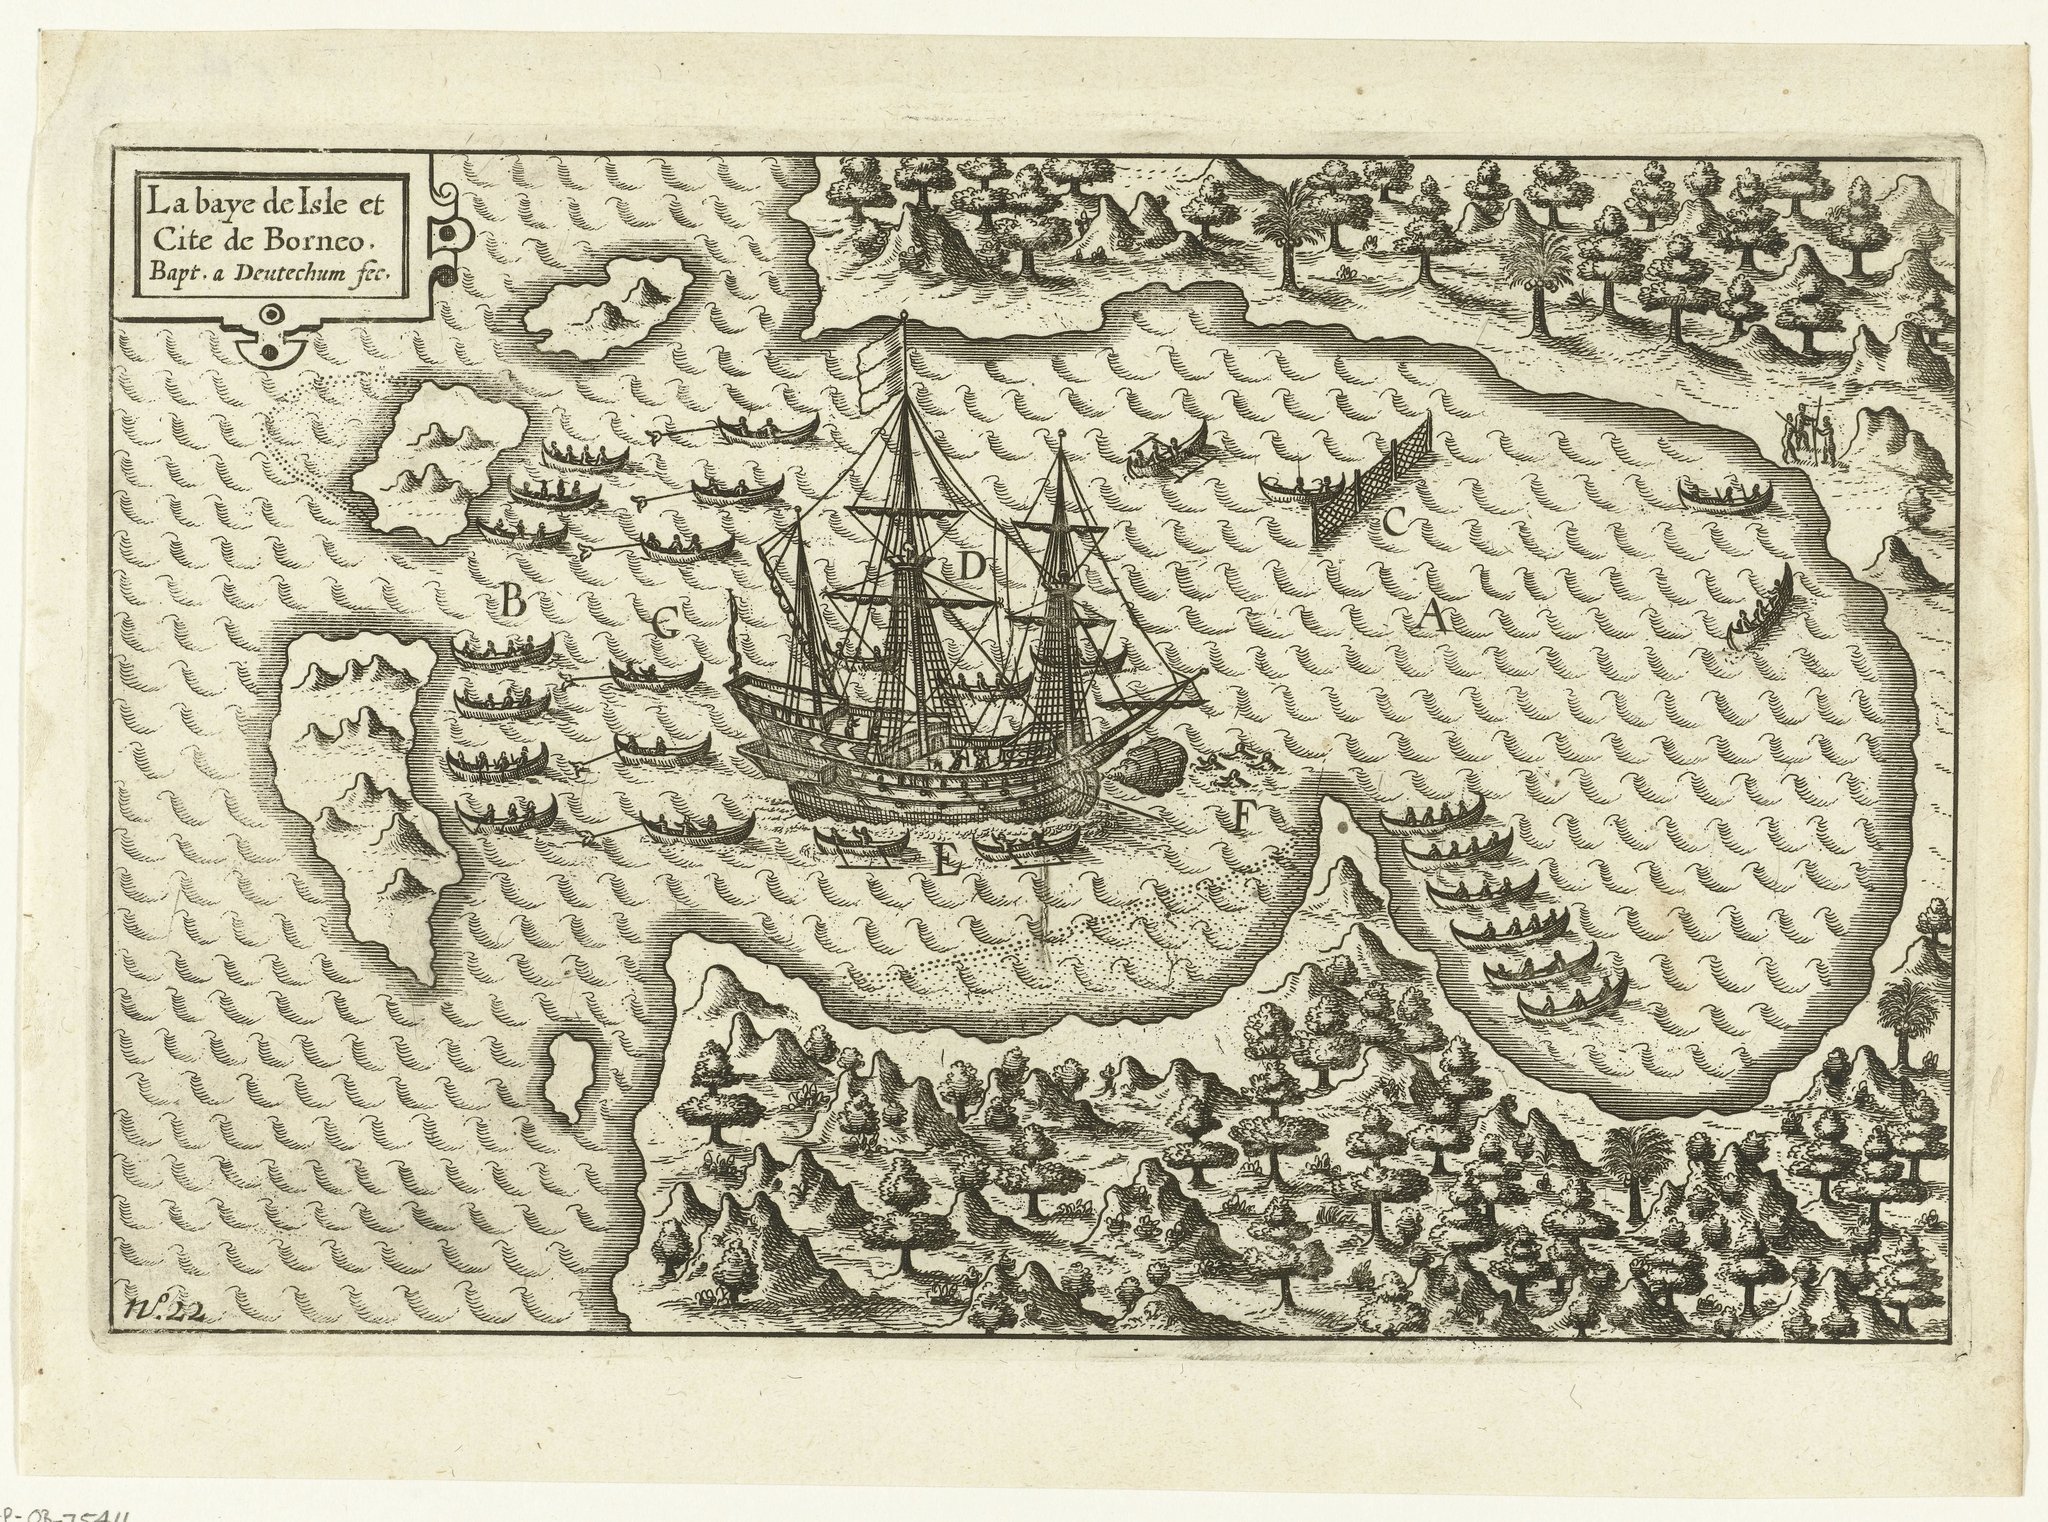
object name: print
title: La baye de Isle et Cite de Borneo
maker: baptista van doetechum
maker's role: print maker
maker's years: -1611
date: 1601-1602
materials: paper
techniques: engraving, etching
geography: northern netherlands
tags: utrecht, landscapes in tropical and sub-tropical regions, exploration, expedition, voyage of discovery, borneo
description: Gebruikt als illustratie eerst in: O. van Noort, Beschryvinghe vande voyagie om den geheelen werelt cloot, ghedaen door Olivier van Noort van Utrecht. ... door de Strate Magellanes, ... langs de custen van Cica, Chili ende Peru, om den gantschen aerden cloot, ende door de Molucques wederom thuys te comen. : Te zeyl gegaen van Rotterdam ... 1598. Ende ... weder ghekeert ... 1601. Daer in dat vertelt wort zyne wonderlijcke avontueren, Jan van Waesberge (II) te Rotterdam en Cornelis Claes te Amsterdam 1602. Later gebruikt in: Oost-Indische ende West-Indische voyagien, Michiel Colijn, Amsterdam 1619 en in deze staat eerst gebruikt in: Beschrijvinge van de Schipvaerd by de Hollanders ghedaen onder 't beleydt ende Generaelschap van Olivier van Noort, door de Straet of Engte van Magallanes, ende voorts de gantsche kloot des Aertbodems om. Opgenomen in: I. Commelin, Begin ende voortgangh, van de Vereenighde Nederlantsche Geoctroyeerde Oost-Indische Compagnie, J. Janssonius, Amsterdam 1646. Genummerd: 22.